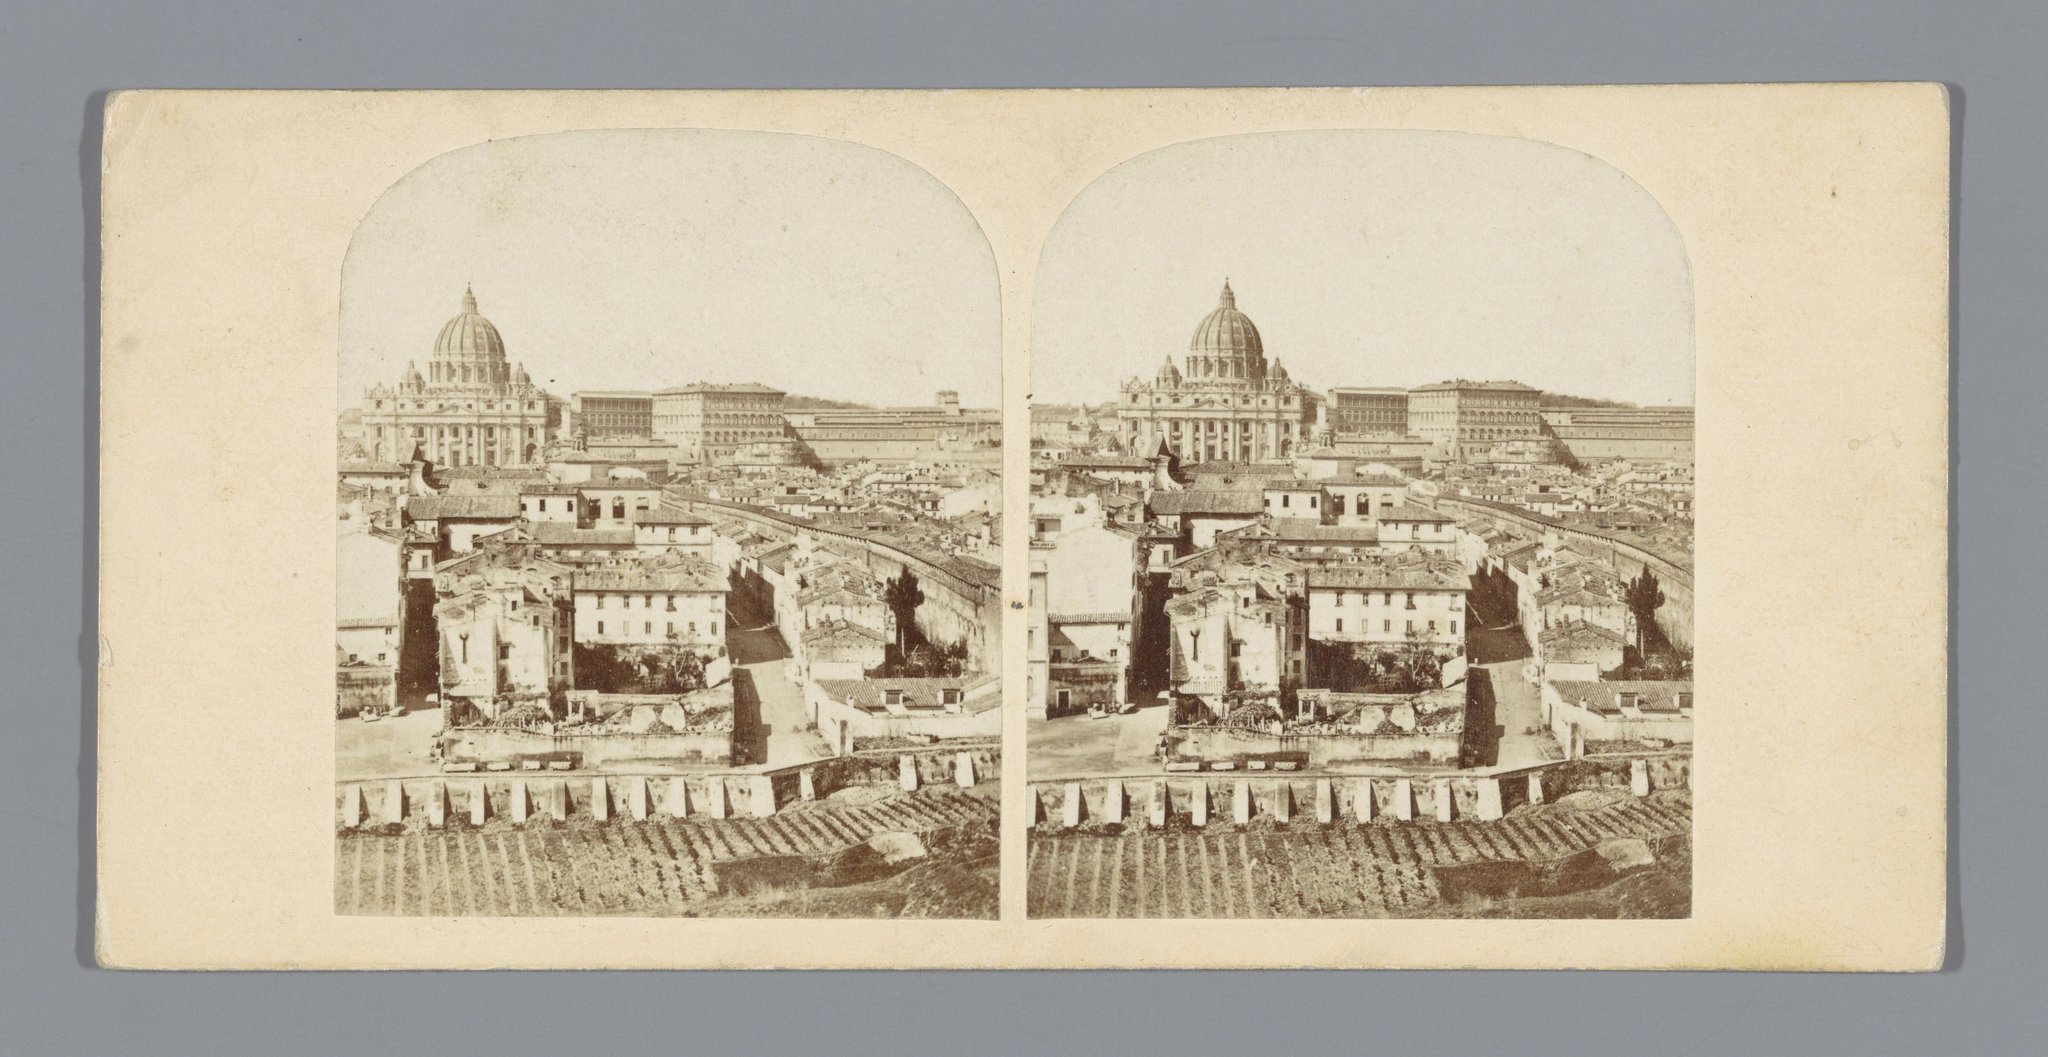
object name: stereograph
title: Gezicht op Rome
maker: Anonymous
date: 1850-1880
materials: cardboard, photographic support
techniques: albumen print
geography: rome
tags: city-view in general; 'veduta', rome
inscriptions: inscription: ‘Panorama de Rome’